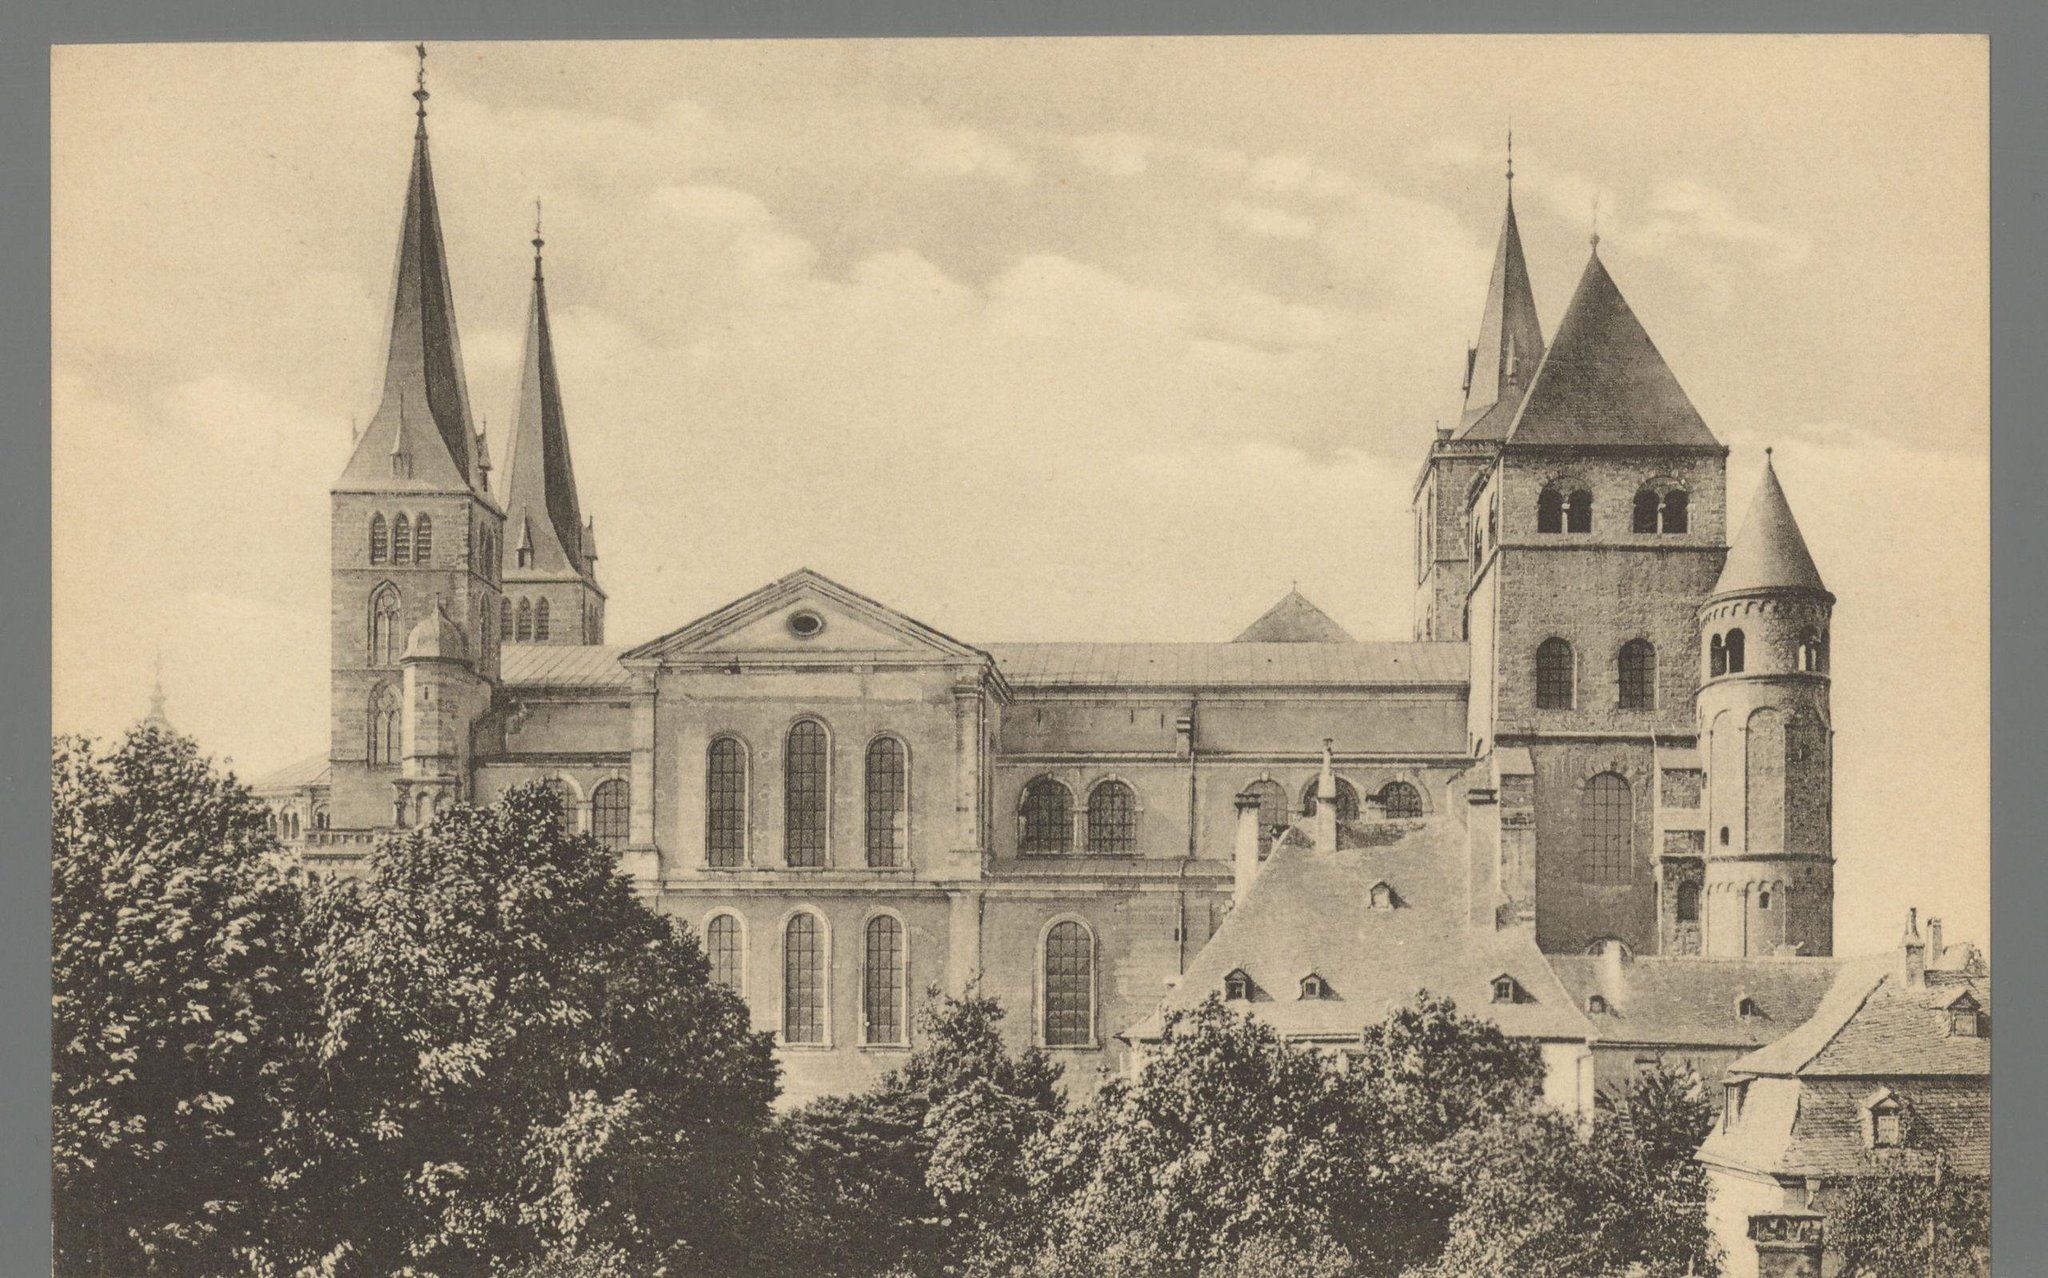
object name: ansichtkaart, prentbriefkaart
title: Dom zu Trier. Nordseite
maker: Anonymous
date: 1905-1930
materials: cardboard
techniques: photograph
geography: trier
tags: church (exterior)